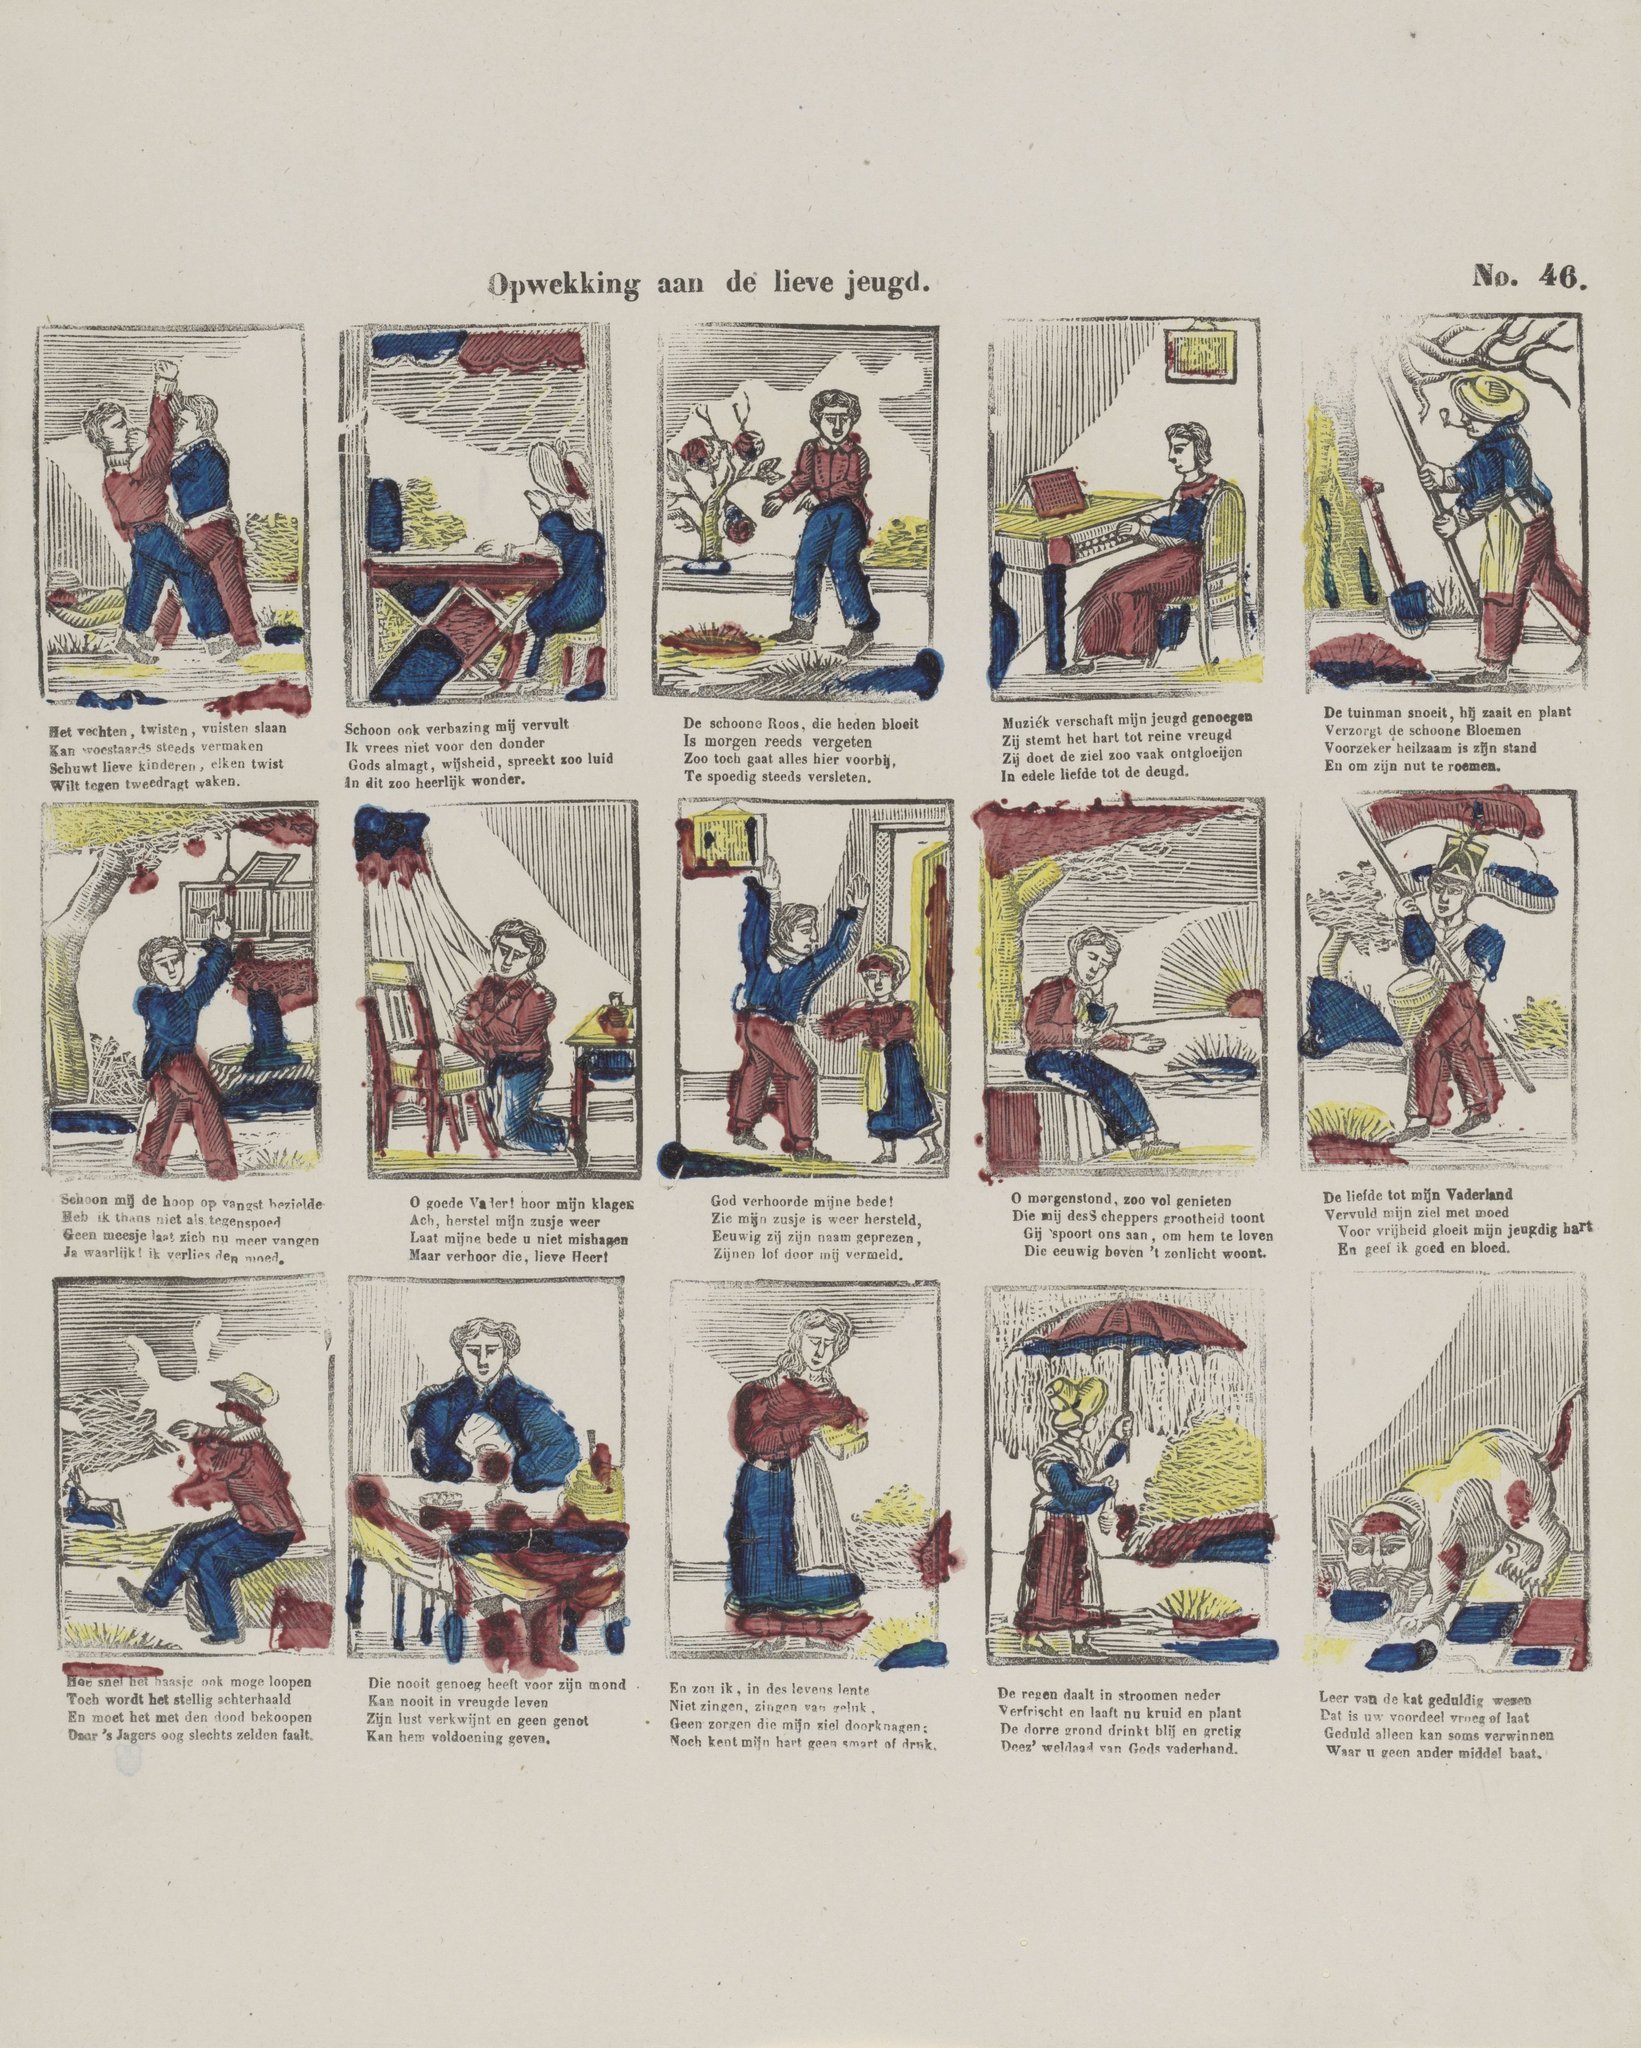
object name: print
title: Opwekking aan de lieve jeugd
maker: Anonymous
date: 1848-1881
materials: paper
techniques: colour, letterpress printing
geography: netherlands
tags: bad behaviour, good behaviour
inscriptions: collector's mark: Lugt 2760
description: Blad met 15 moraliserende taferelen over goed en slecht gedrag van mensen. Onder elke afbeelding een vierregelig vers. Genummerd rechtsboven: No. 46.